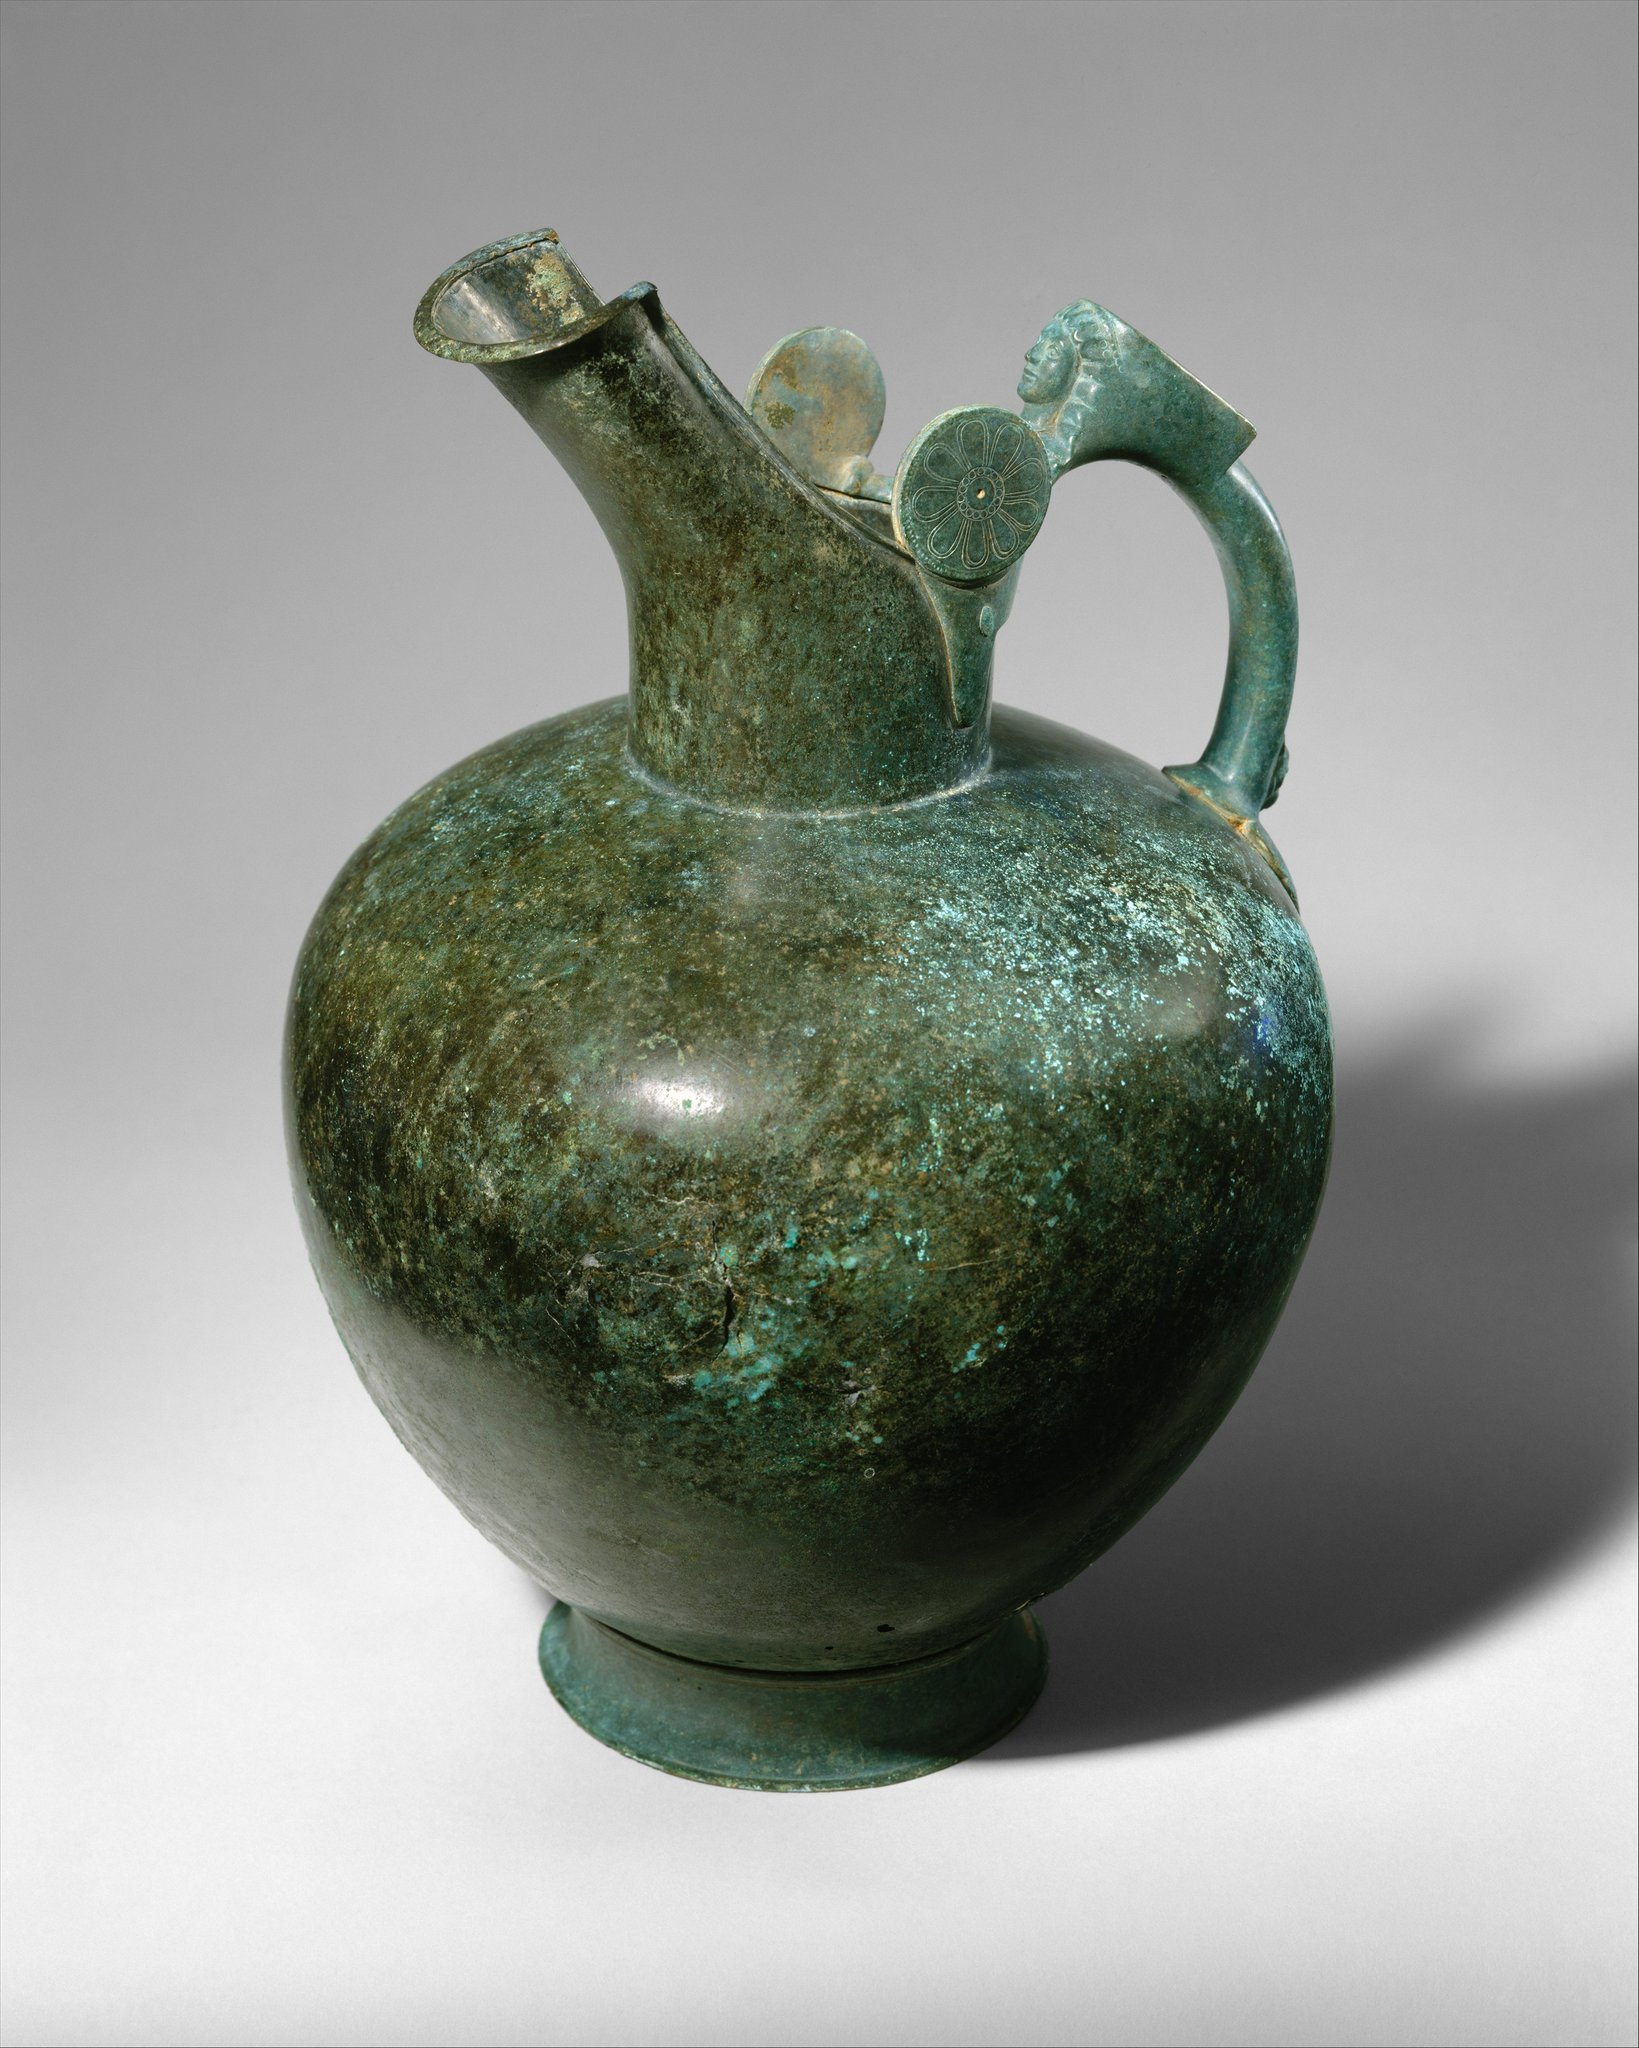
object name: oinochoe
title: Bronze oinochoe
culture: greek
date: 567-535 BCE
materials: bronze